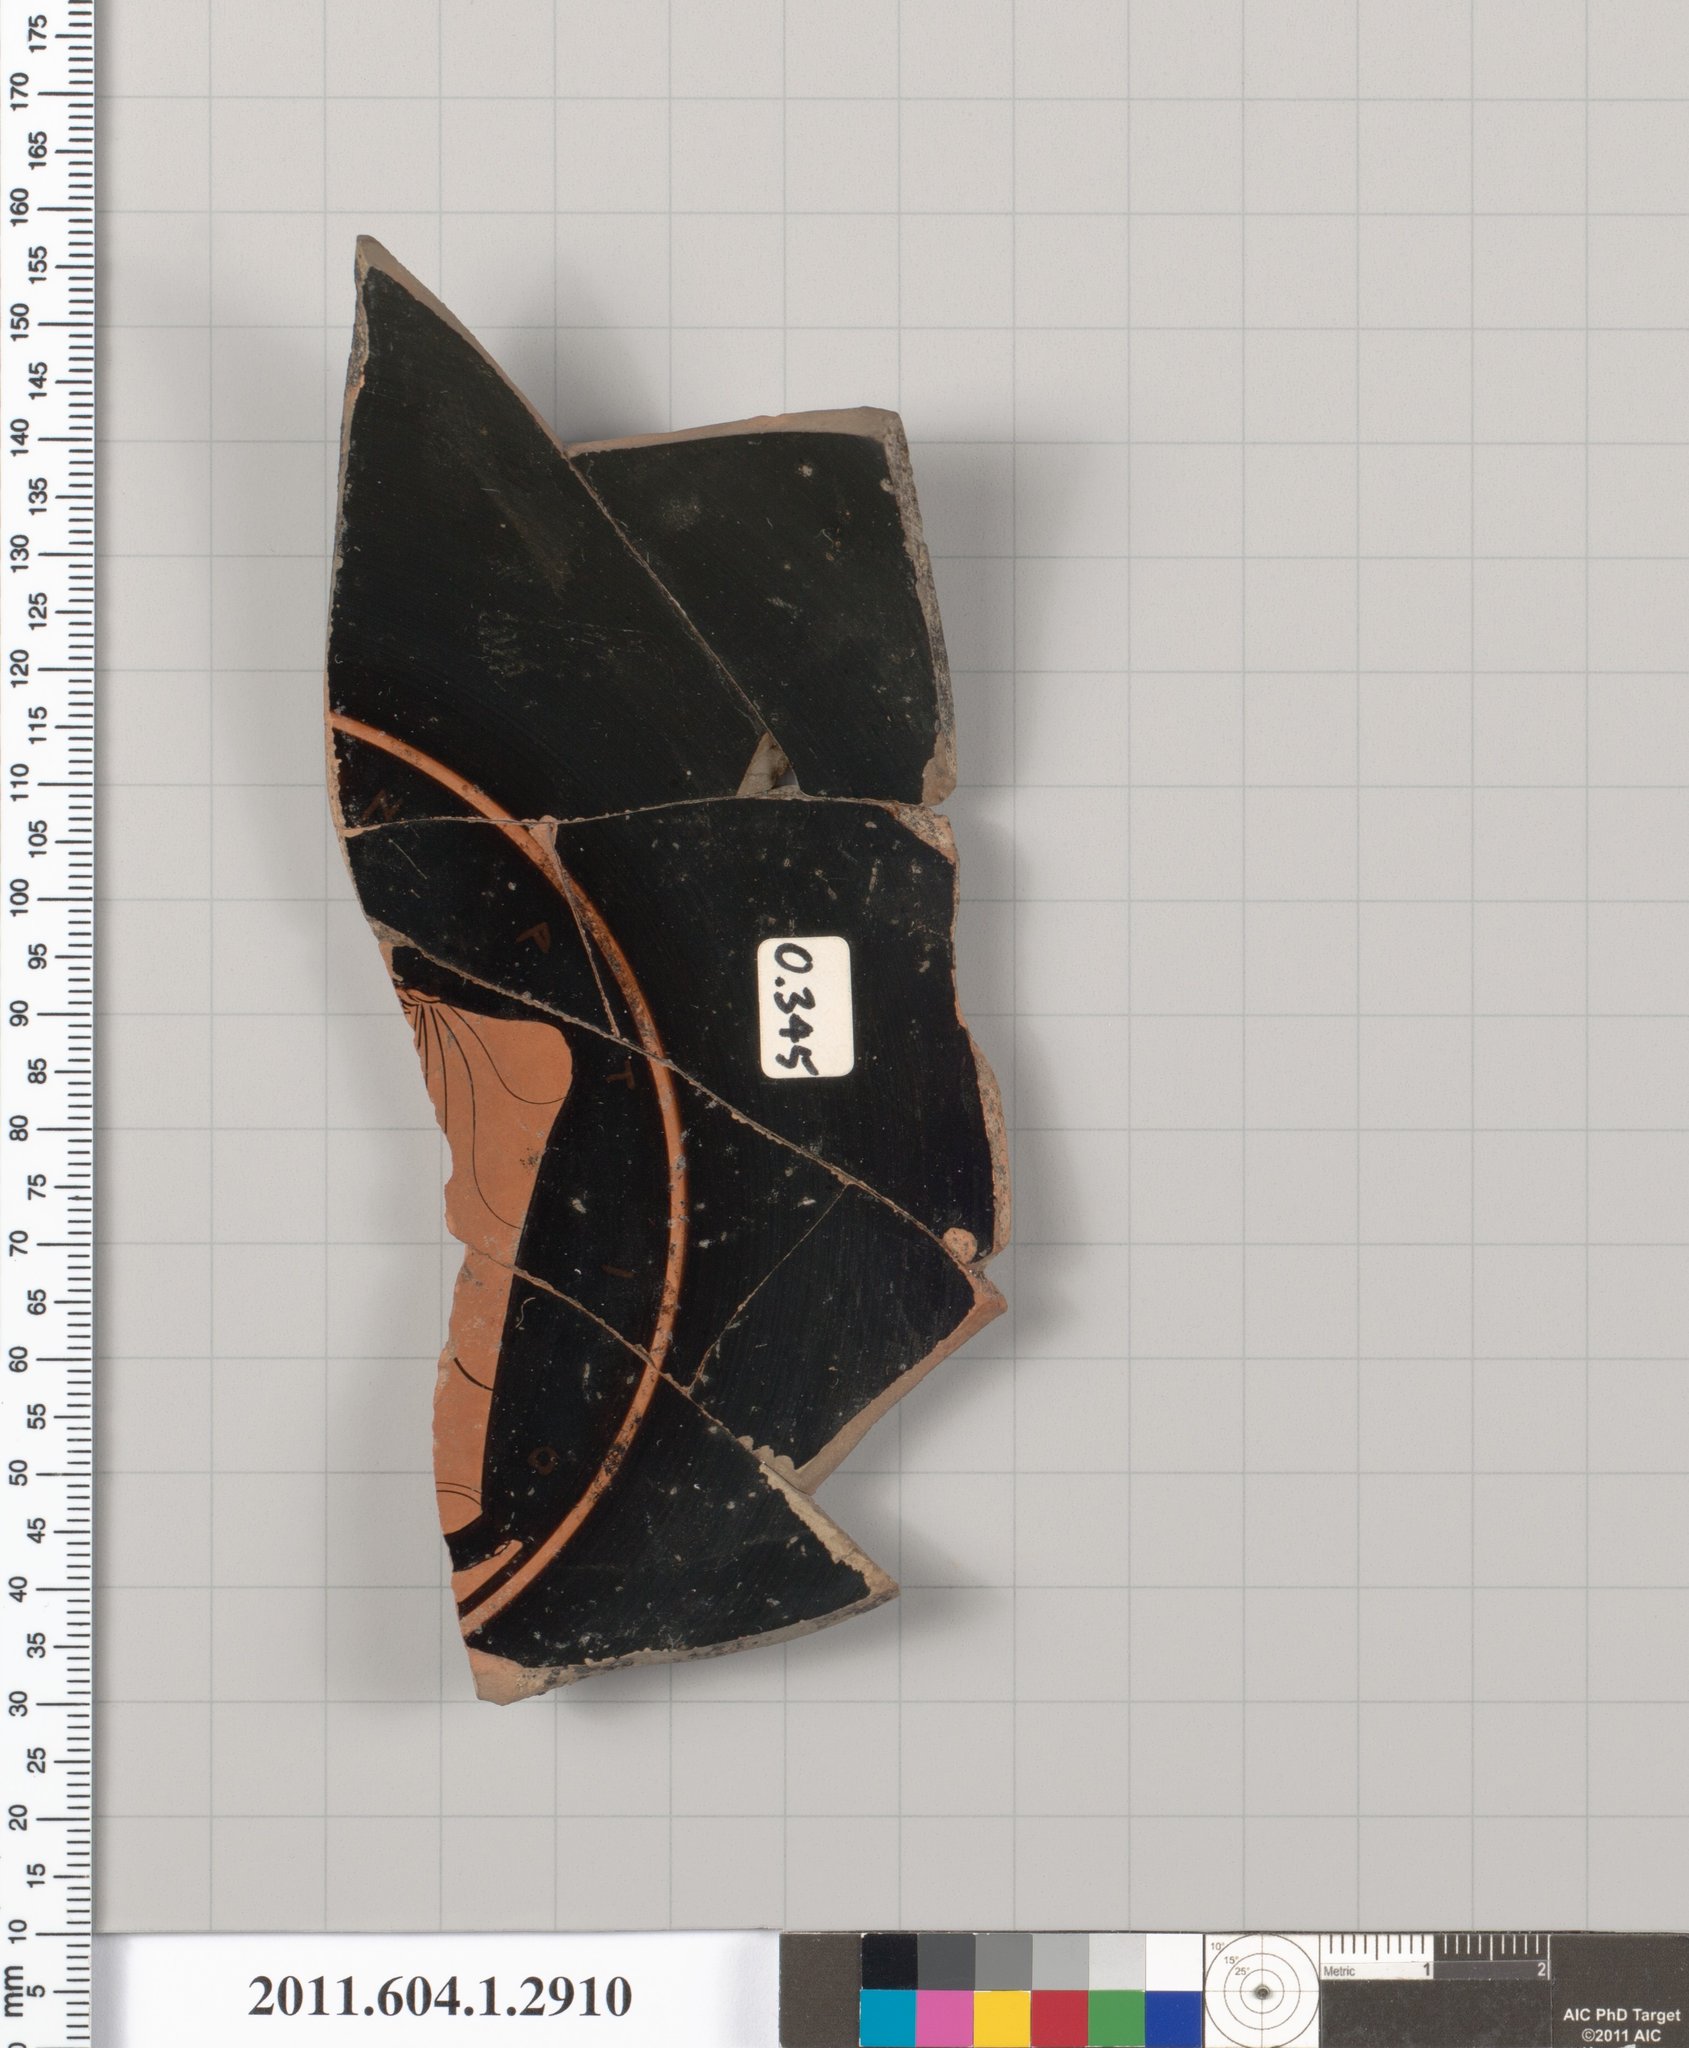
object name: kylix fragment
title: Terracotta fragment of a kylix (drinking cup)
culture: greek, attic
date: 520-500 BCE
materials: terracotta